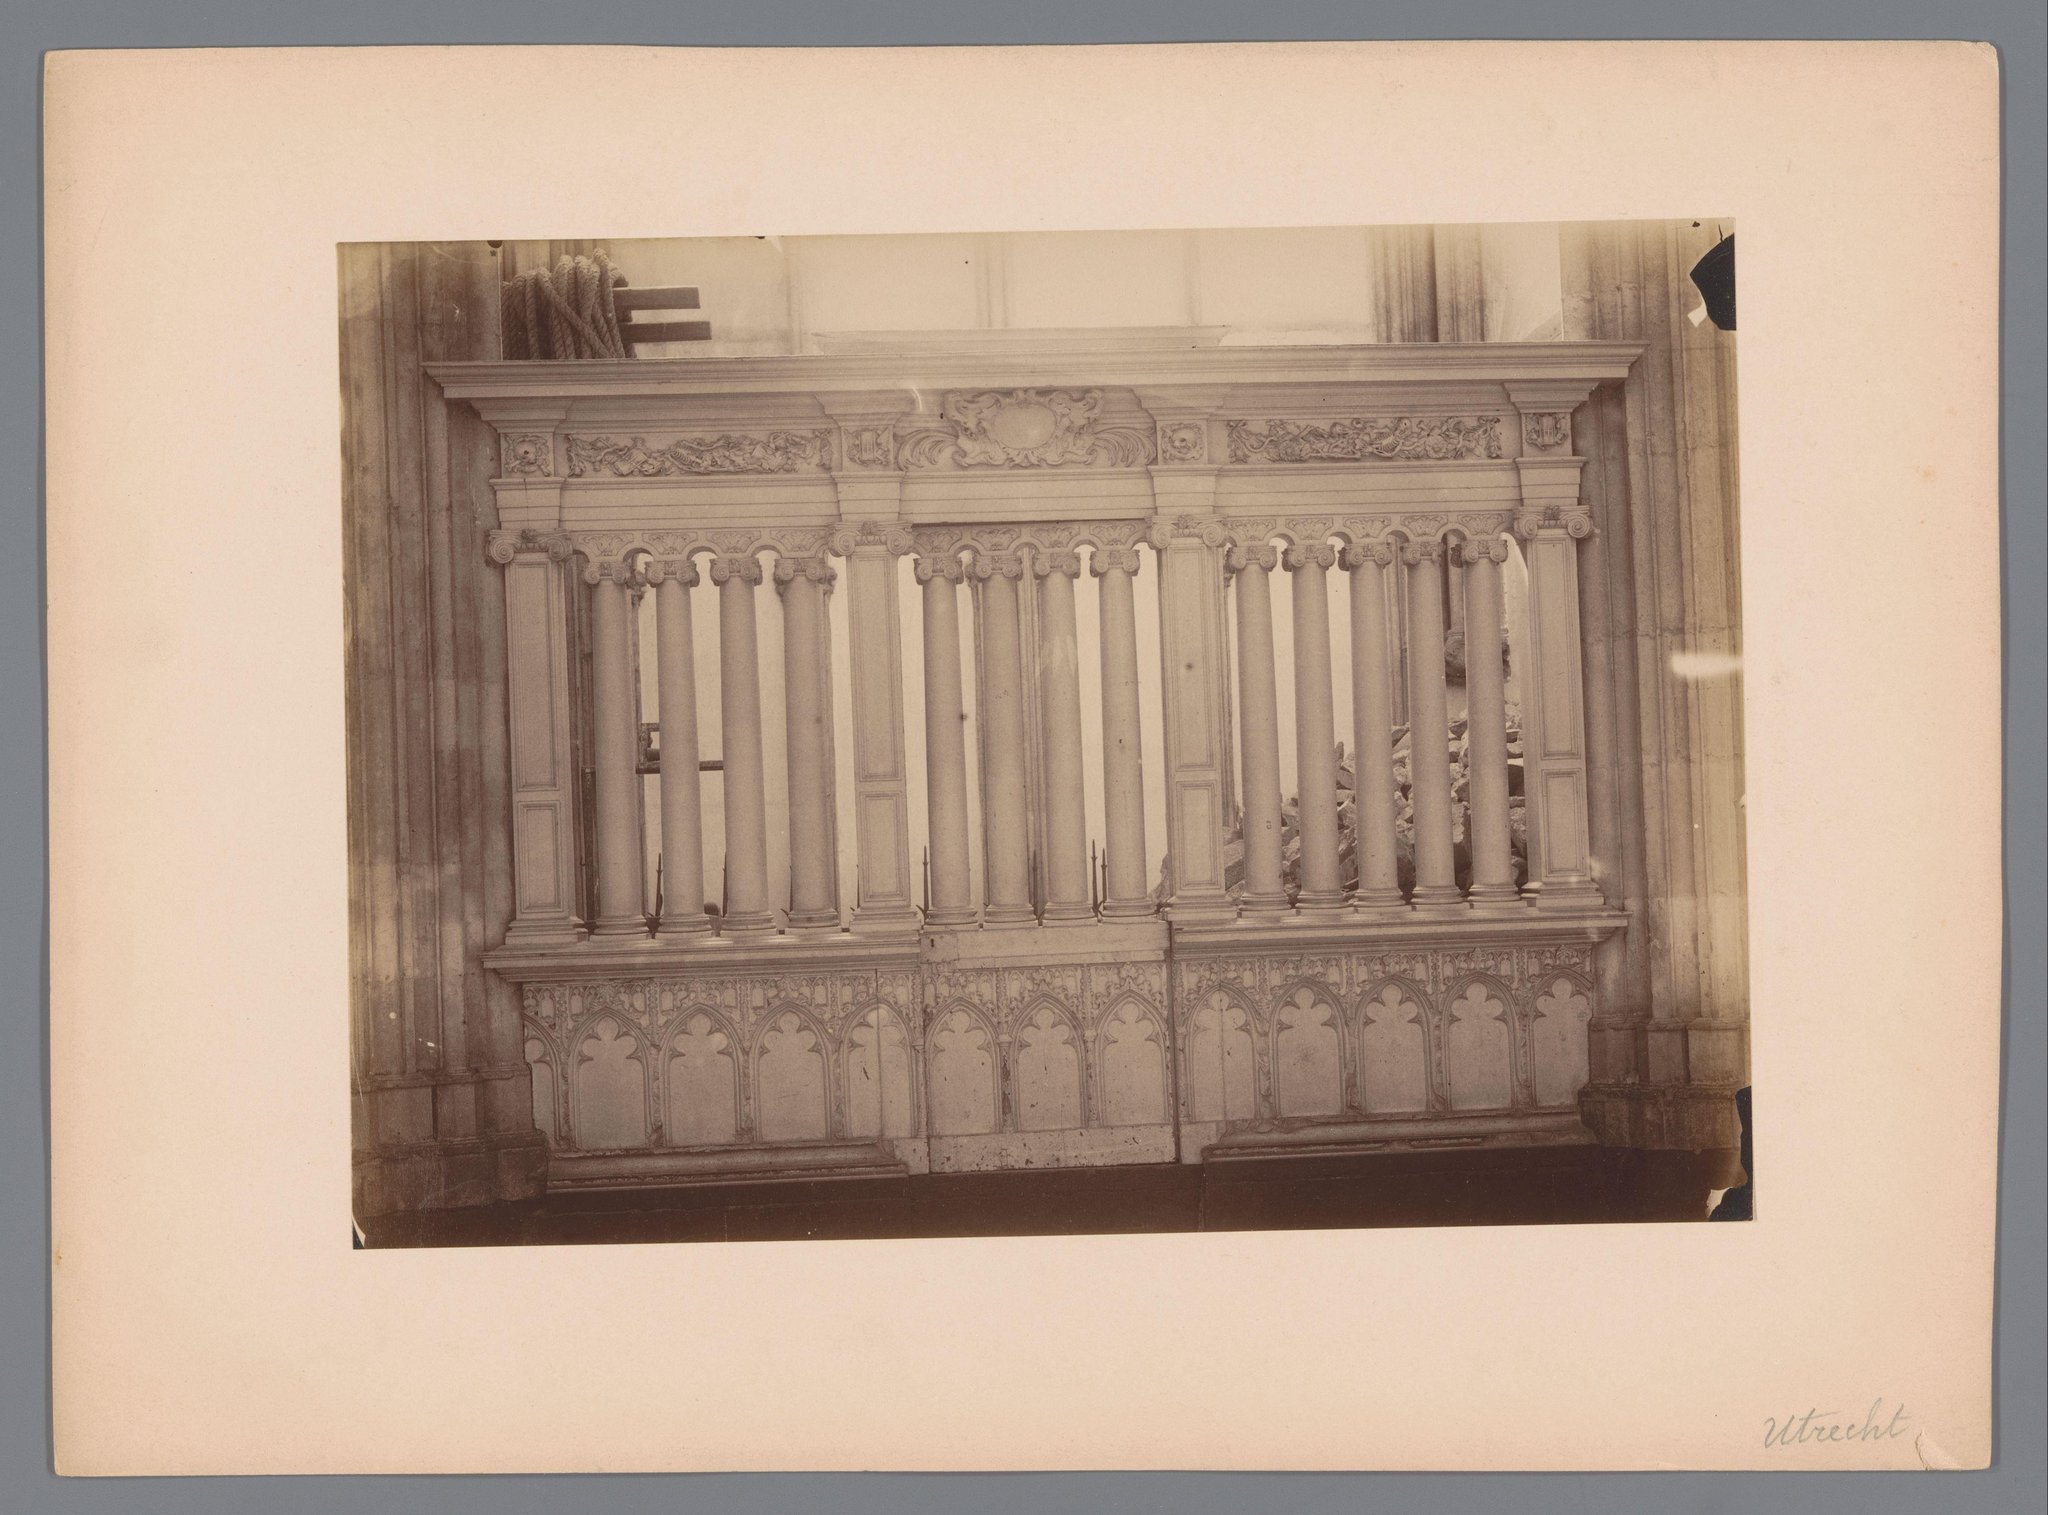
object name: photograph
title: Koorhek in de Dom van Utrecht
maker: anoniem (monumentenzorg)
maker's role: fotograaf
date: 1891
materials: cardboard, photographic support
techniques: albumen print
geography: utrecht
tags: parts of church interior: choir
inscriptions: annotation: ‘Domkerk te Utrecht/ Afsluiting hek/ sept 1891’, annotation: ‘Utrecht’